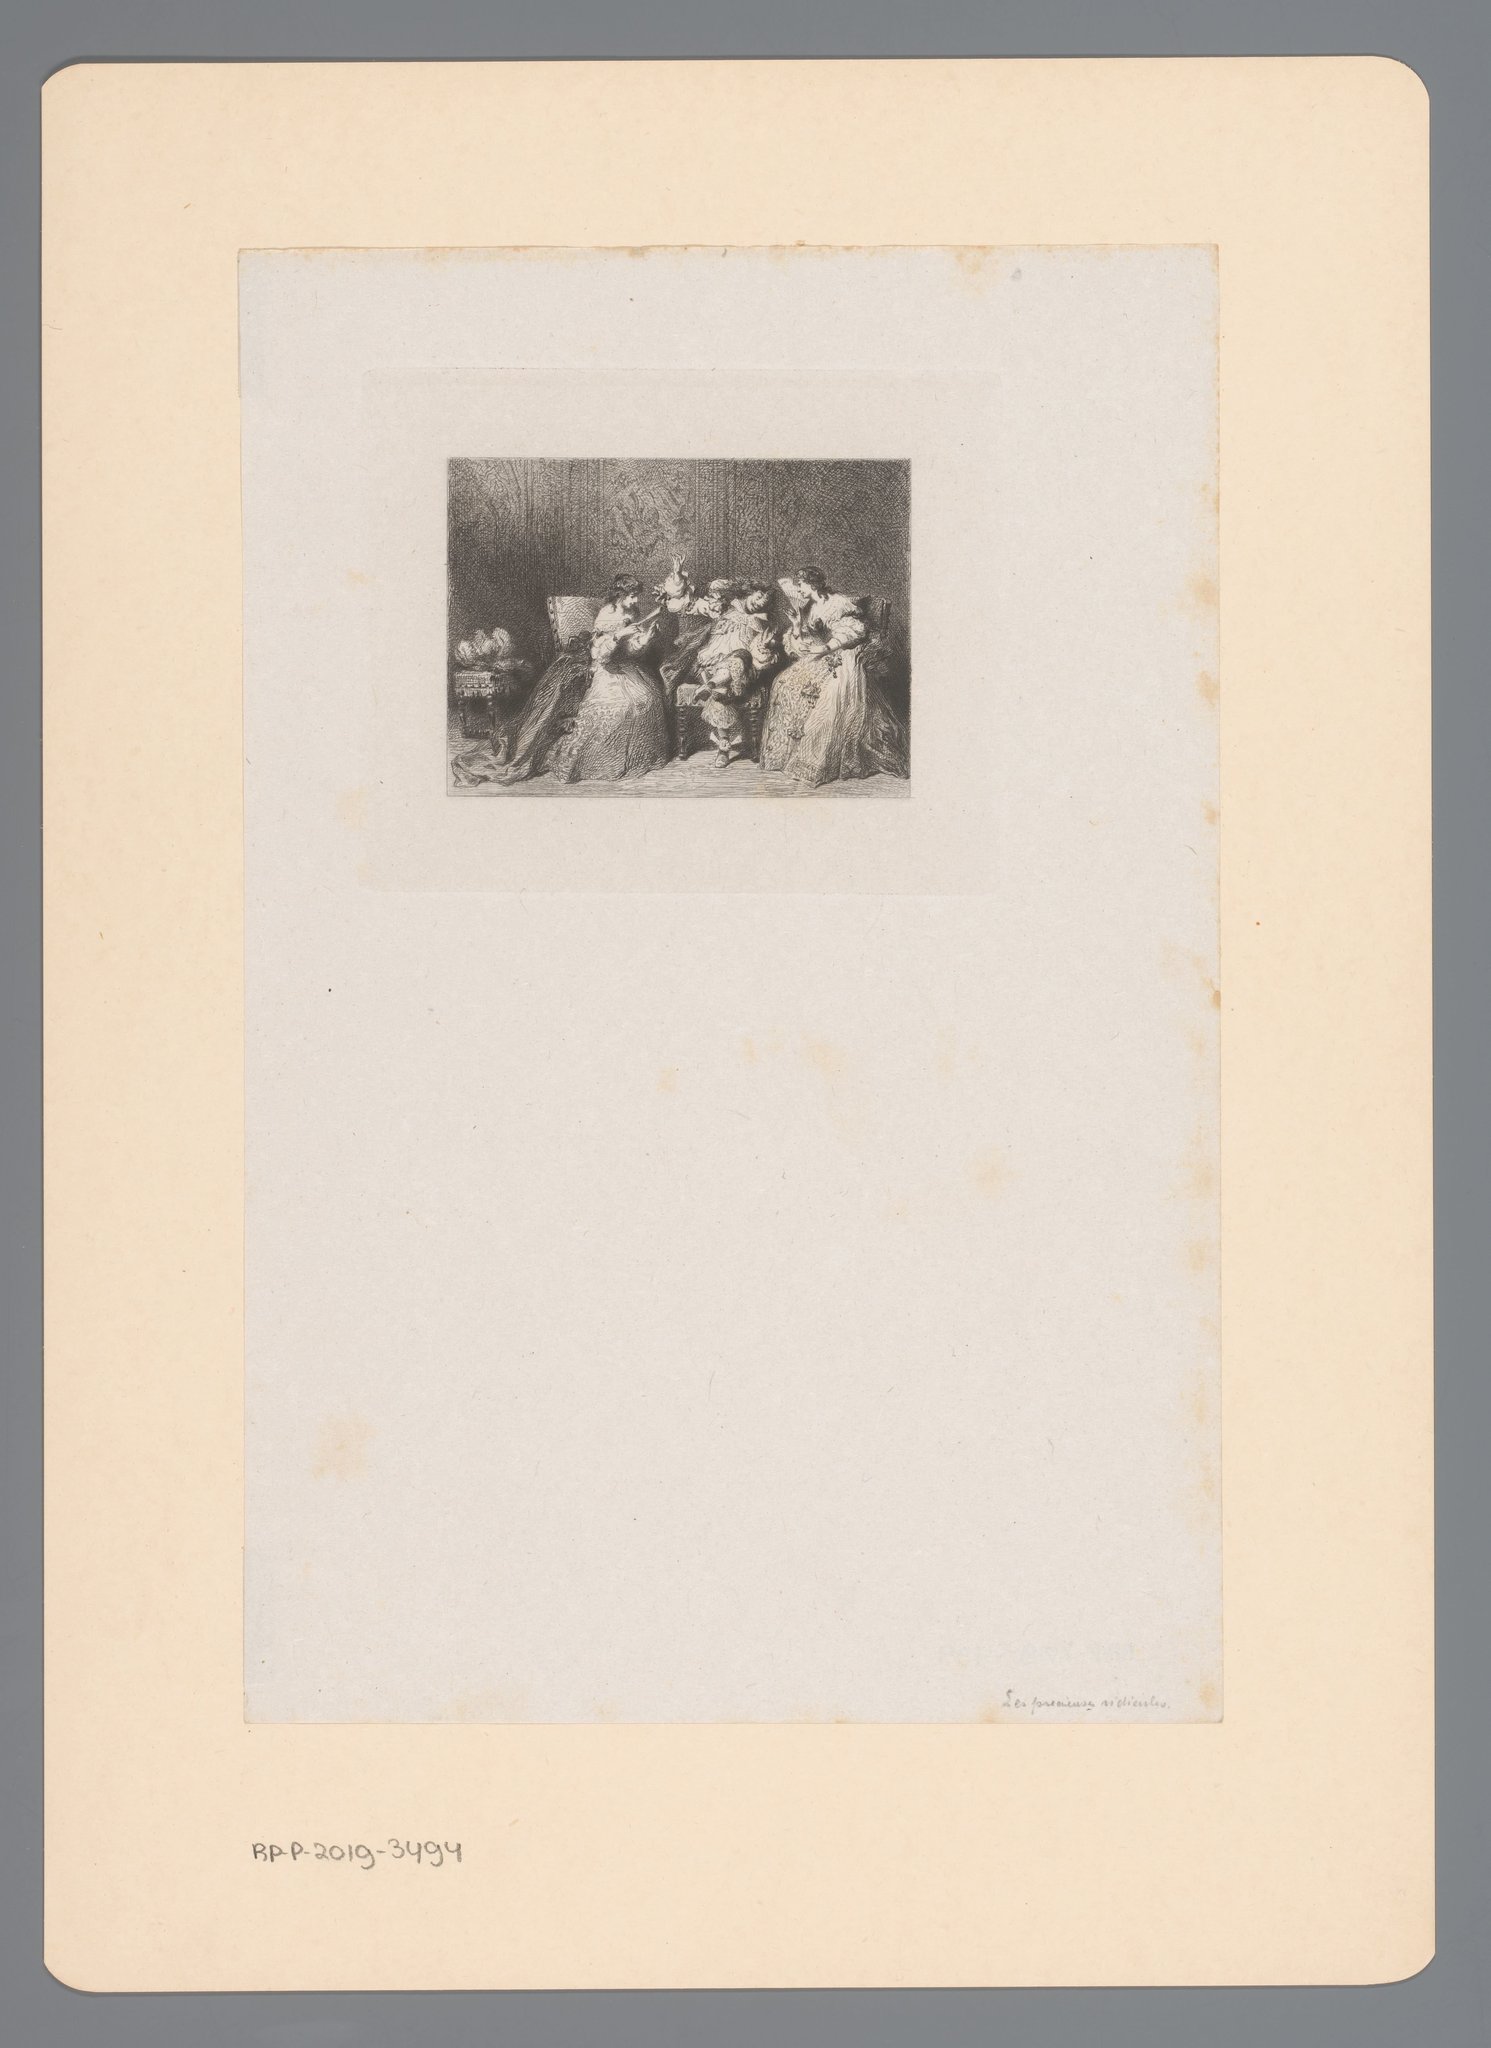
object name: print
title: Molière Théatre Choisi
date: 1878-1879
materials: paper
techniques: drypoint, etching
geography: tours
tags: theatre, theatrical performance, private festivities, merry company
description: Scène uit "Les Précieuses Ridicules" van Molière.